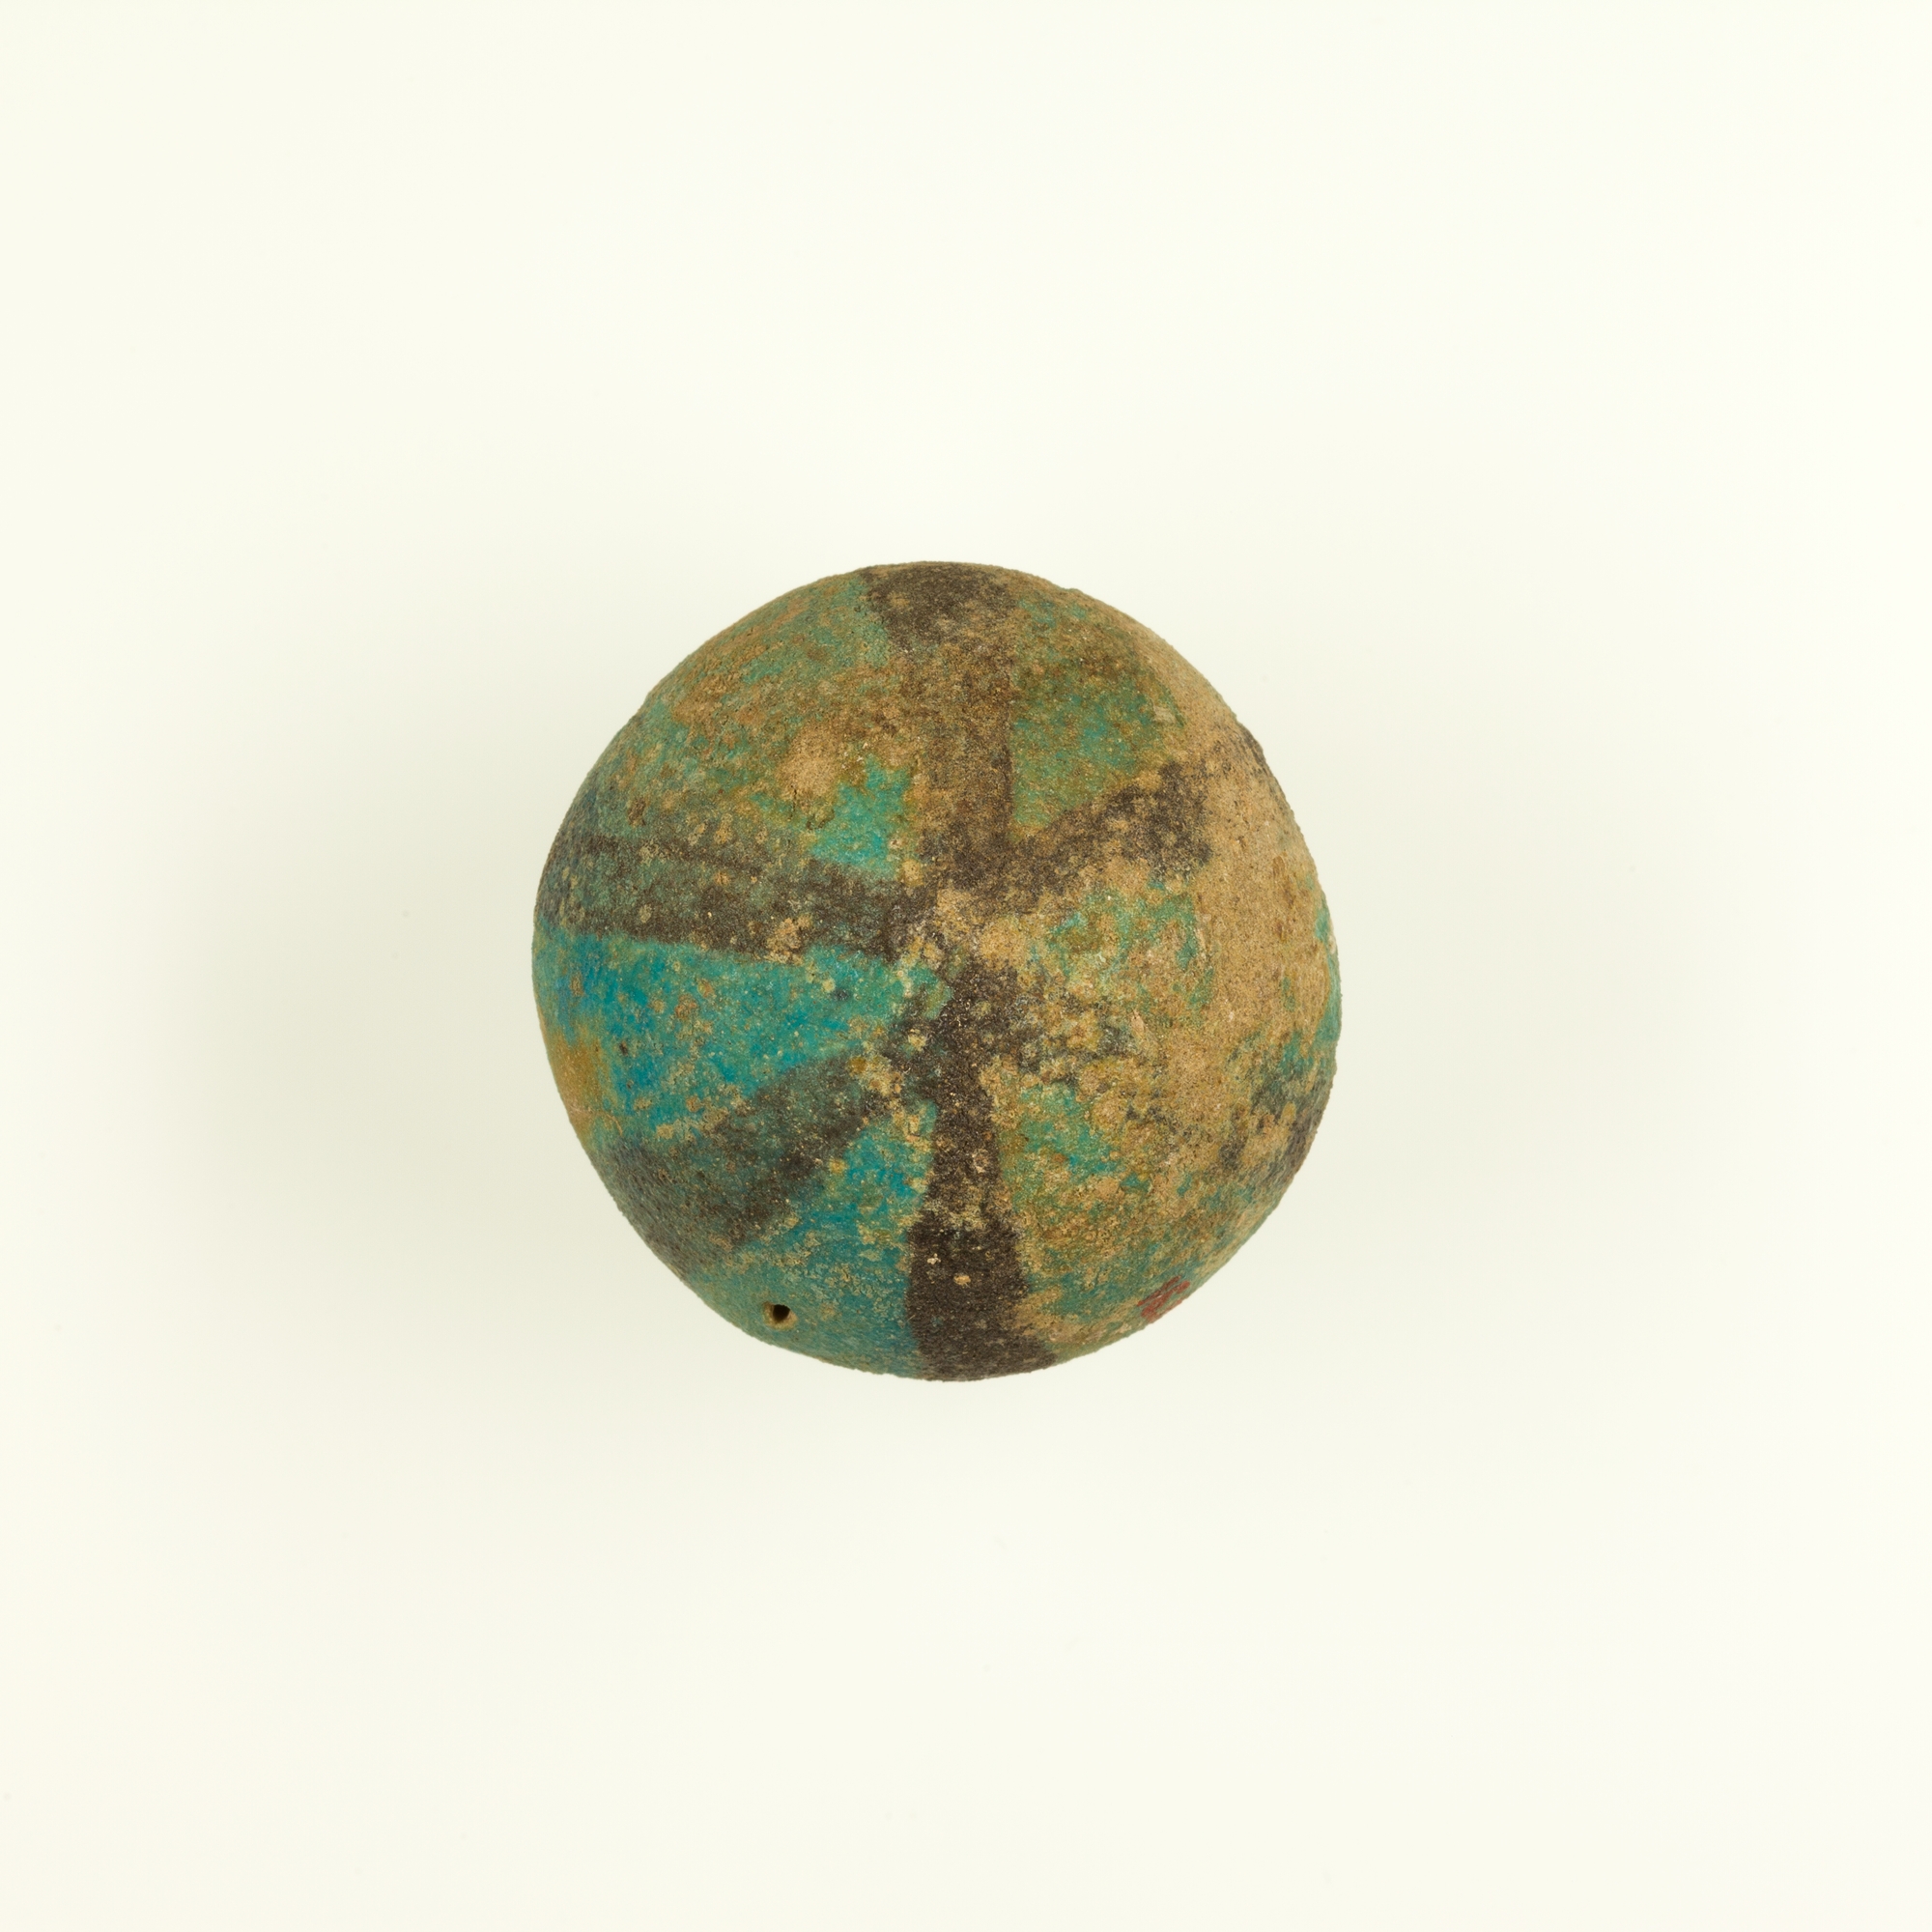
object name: bead, ball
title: Large Ball Bead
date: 1981-1458 BCE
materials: faience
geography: egypt